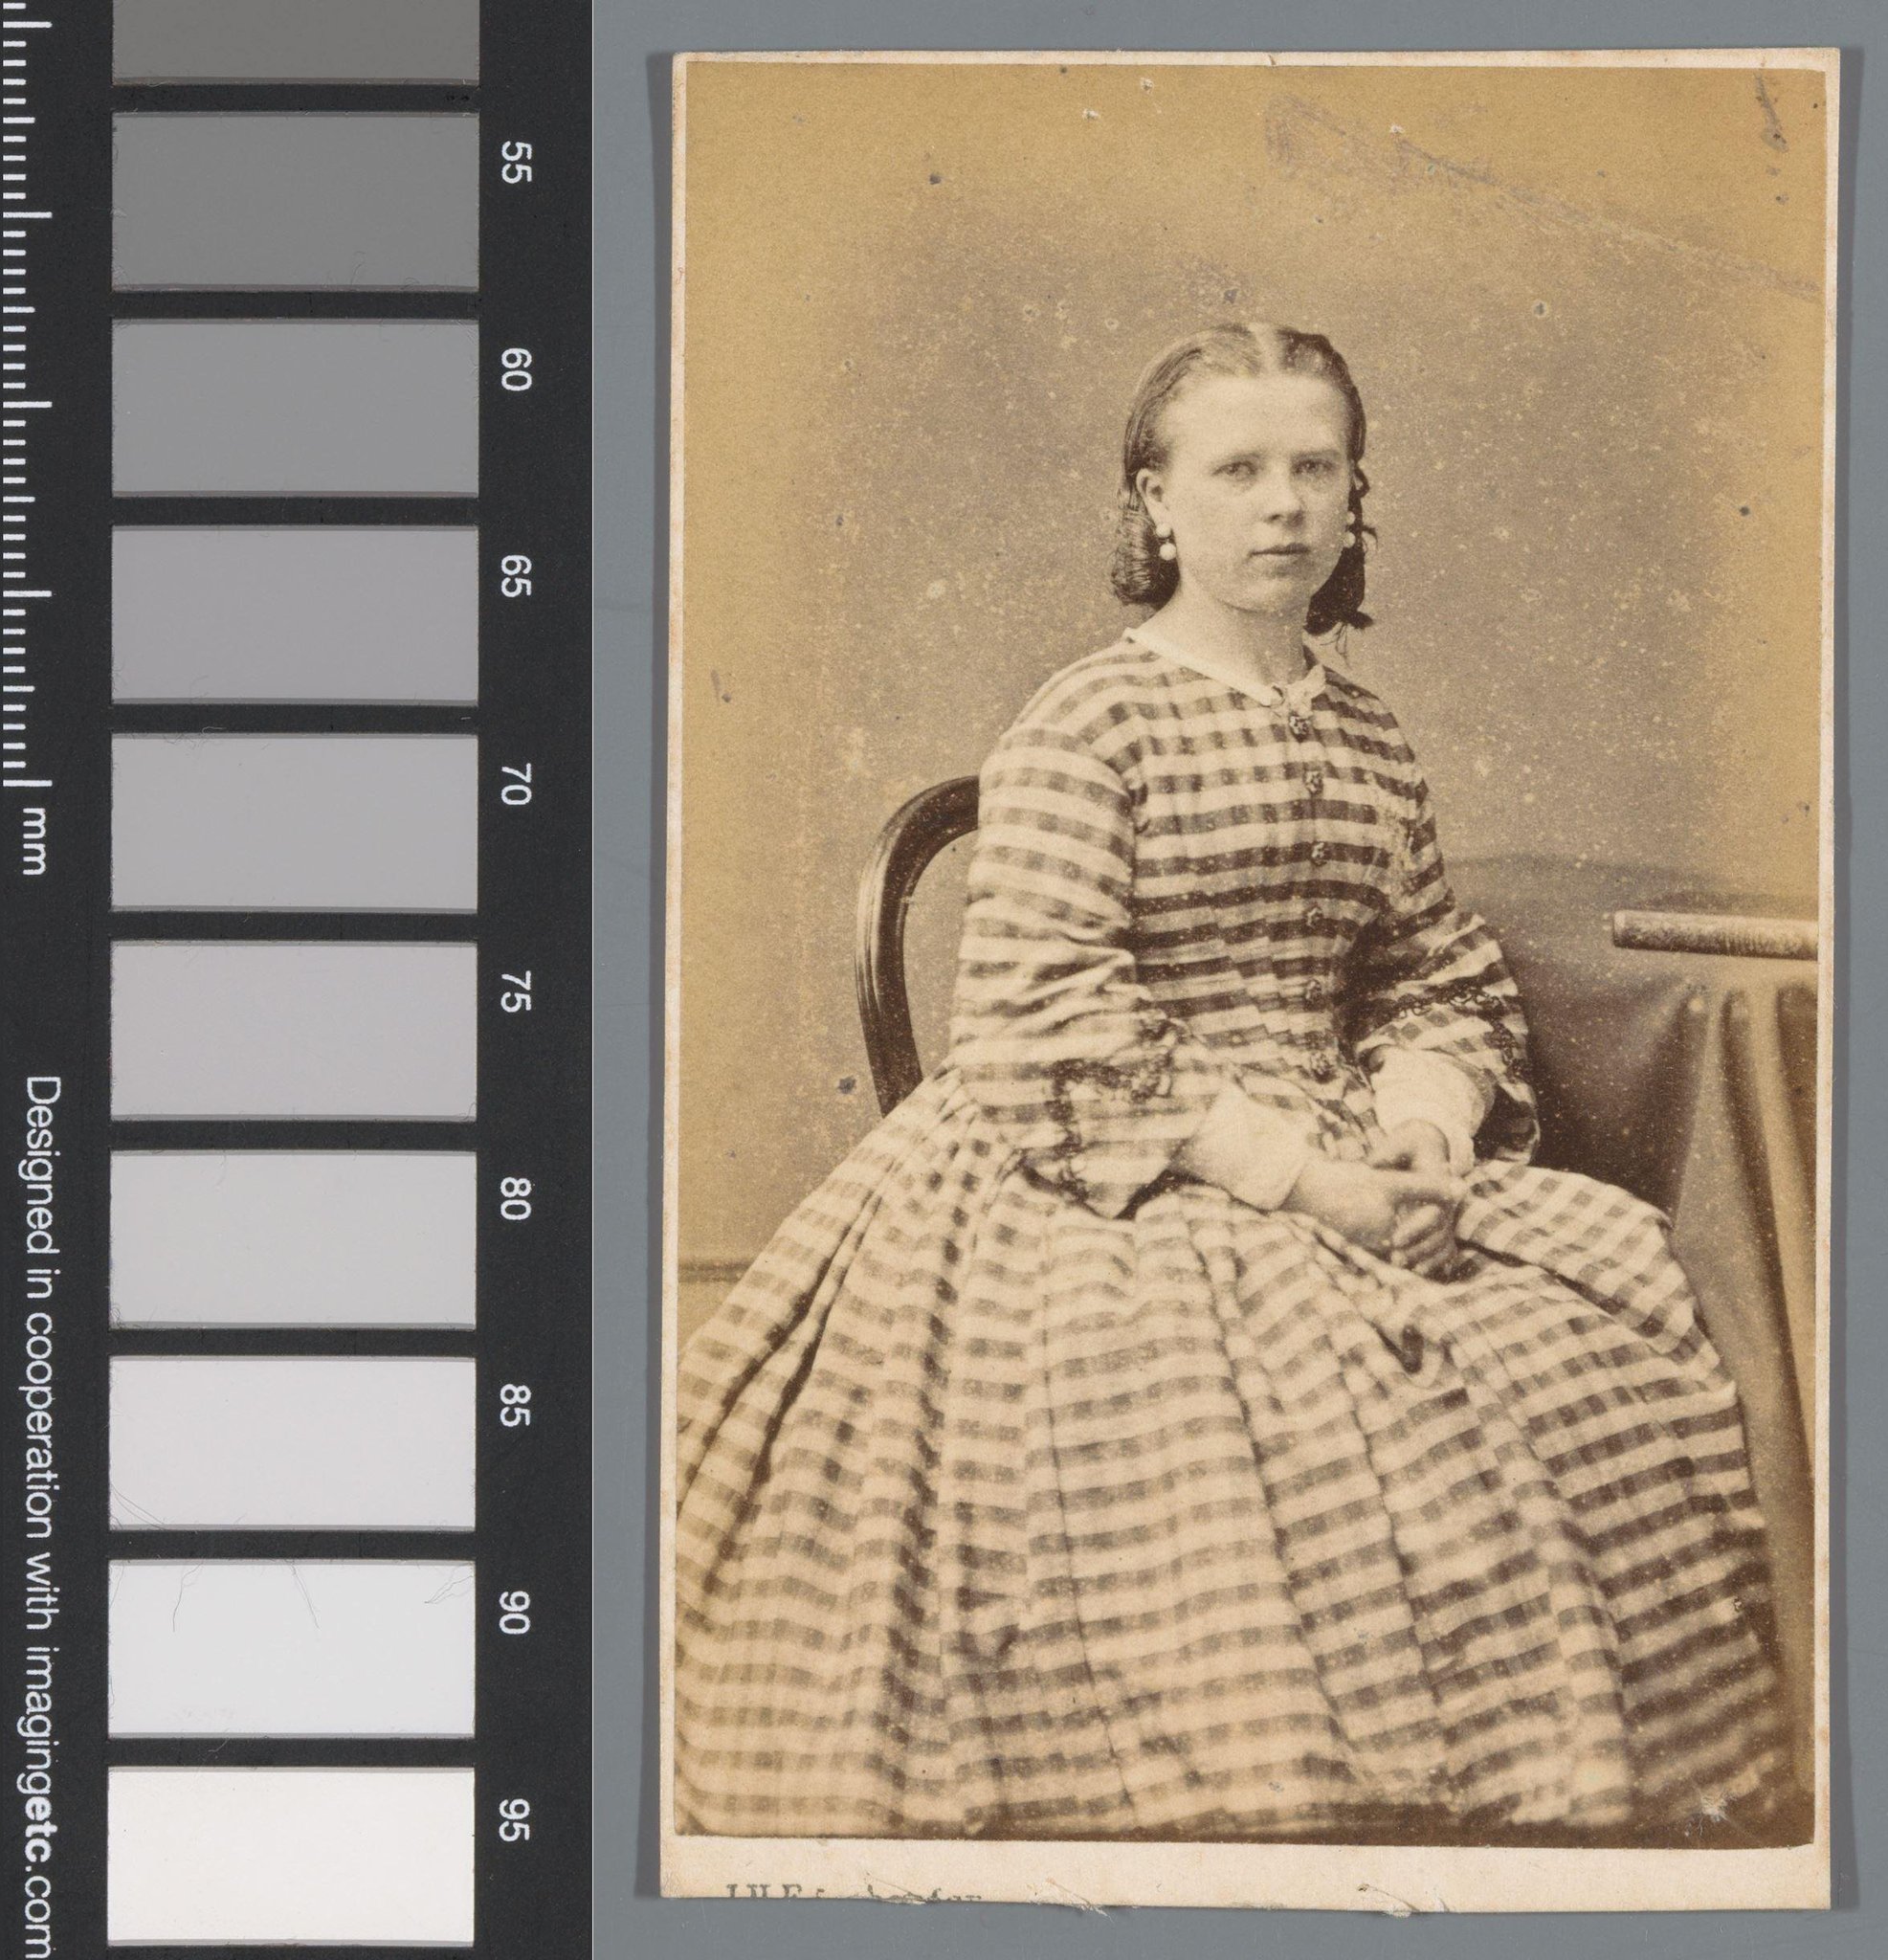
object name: photograph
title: Portret van een onbekende vrouw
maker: johannes hinderikus egenberger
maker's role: draughtsman, print maker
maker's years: 1822-1897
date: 1864-1880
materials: cardboard, paper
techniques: albumen print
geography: groningen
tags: sitting figure, historical persons - bb - woman